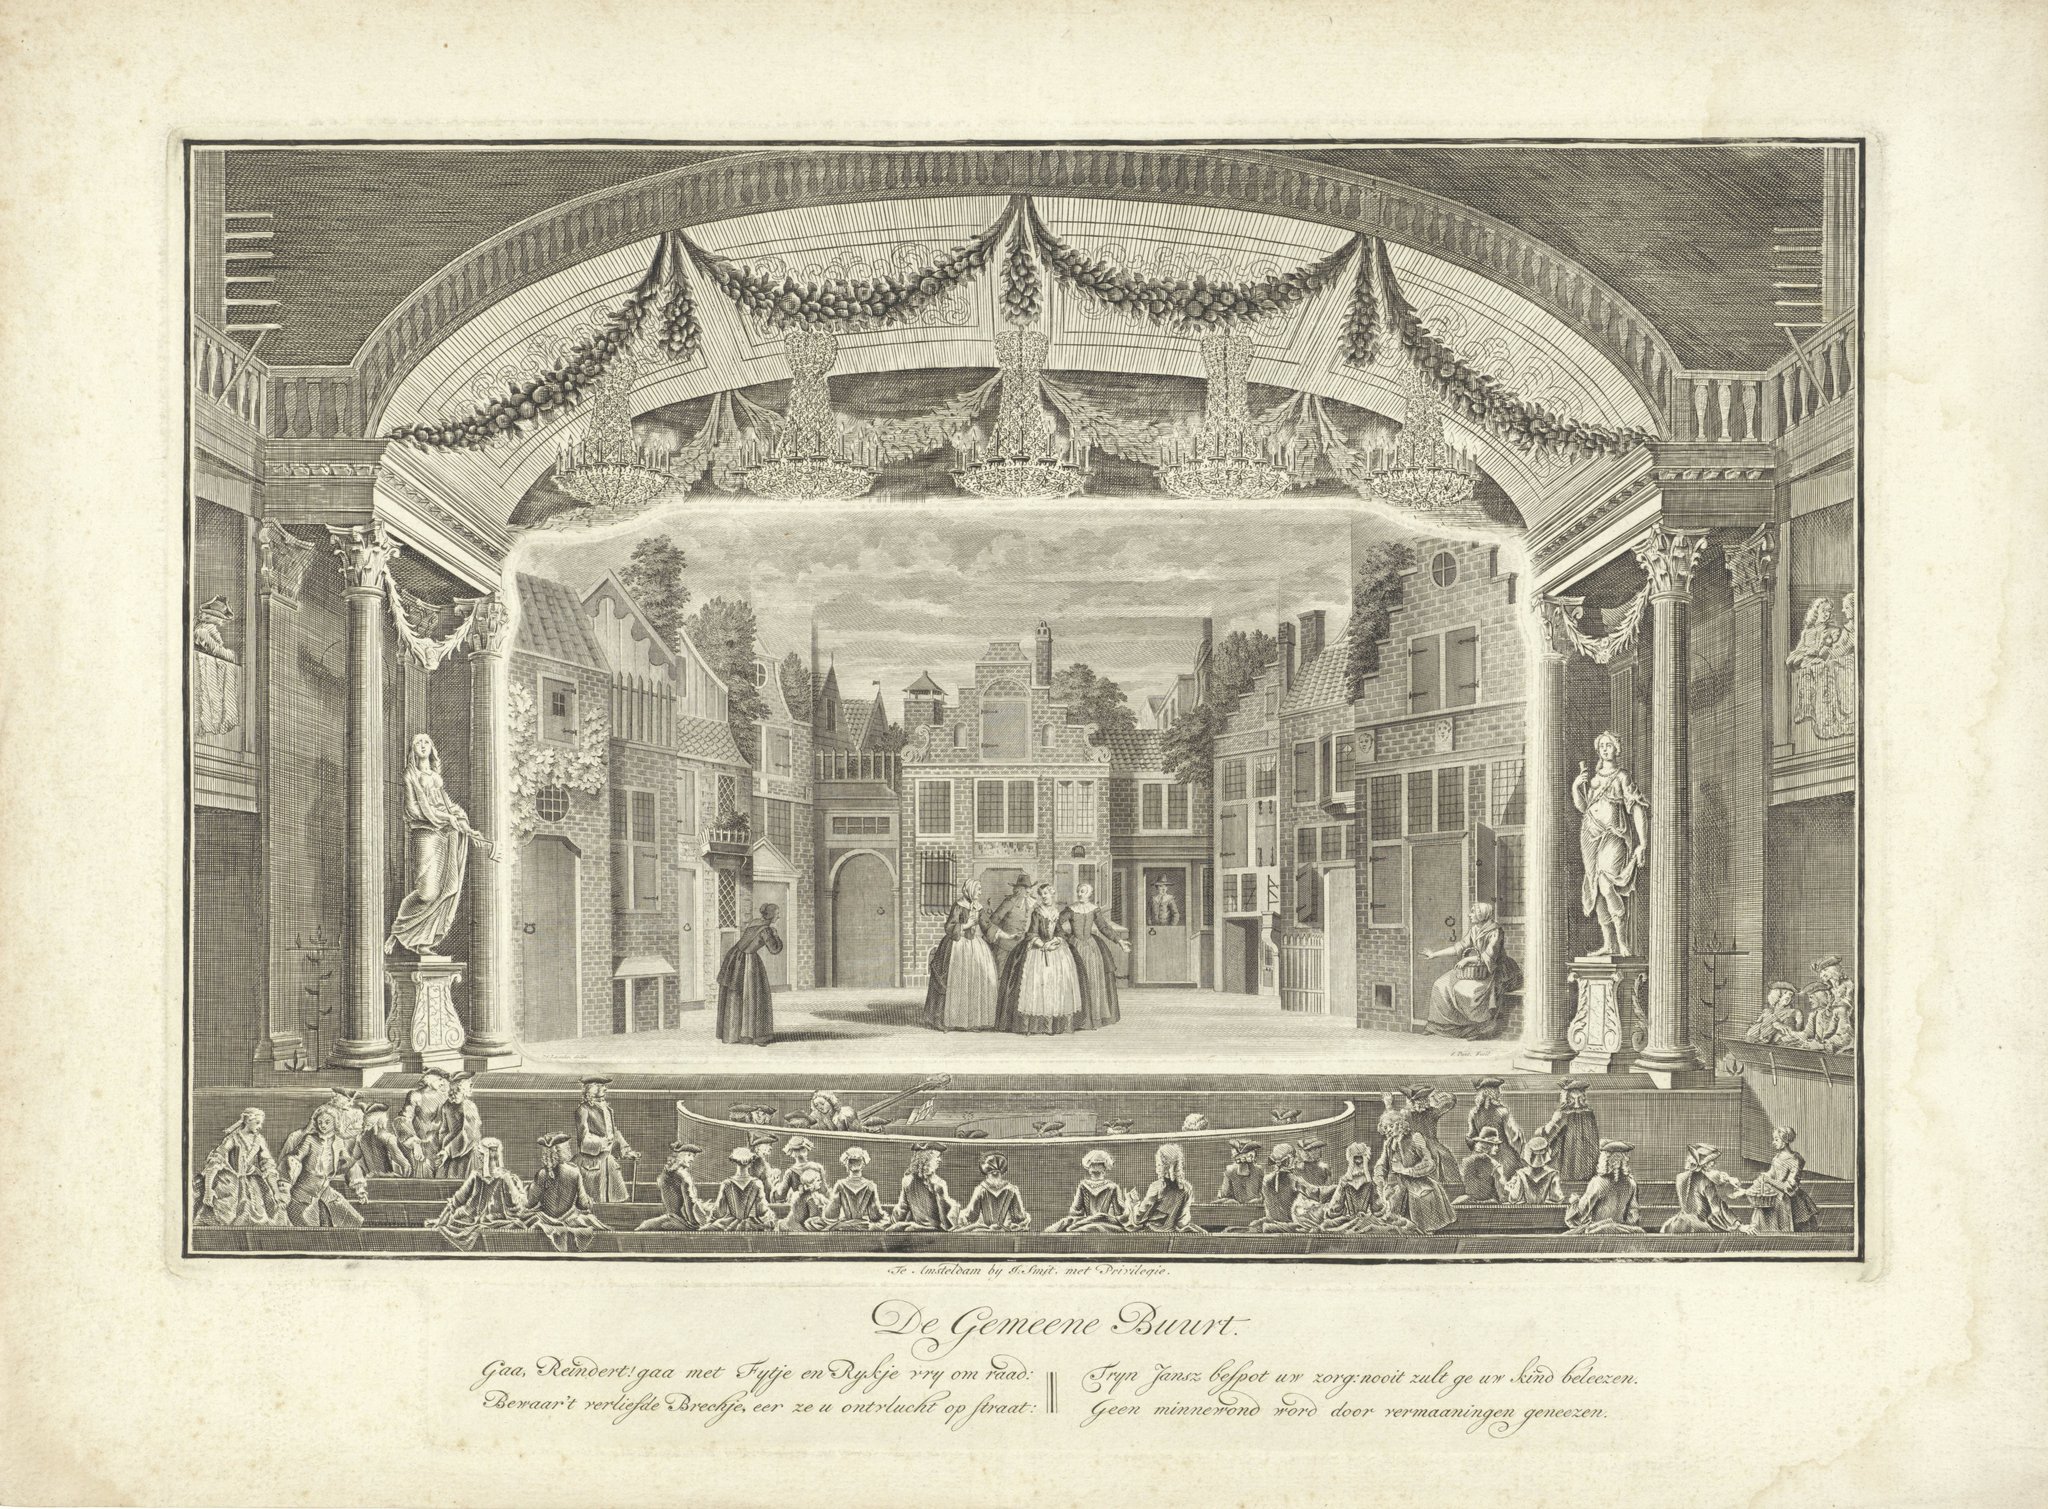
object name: print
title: Schouwburg met toneeldecor: De Gemeene Buurt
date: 1760-1765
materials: paper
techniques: engraving, etching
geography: amsterdam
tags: theatre, theatrical performance, stage design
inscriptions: caption: ‘Gaa, Reindert ! gaa met Fijtje en Rijkje vrij om raad... Geen minnewond word door vermaaningen geneezen.’, collector's mark: Lugt 2228, address: ‘te Amsterdam, by J. Smit, met Privilegie.’, title: ‘De Gemeene Buurt.’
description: Toneelvoorstelling in de Amsterdamse Schouwburg op de Keizersgracht met het coulissendecor De Gemeene Buurt met scène uit: Het Verliefde Brechje. Het decor gedrukt van een aparte plaat binnen een passe-partout met de zaal, zijloges, orkestbak en de façade van het toneel met zuilen, guirlandes en kroonluchters. De titel en een vierregelig vers ook gedrukt van een aparte plaat. Onderdeel van een serie van twaalf toneeldecors.